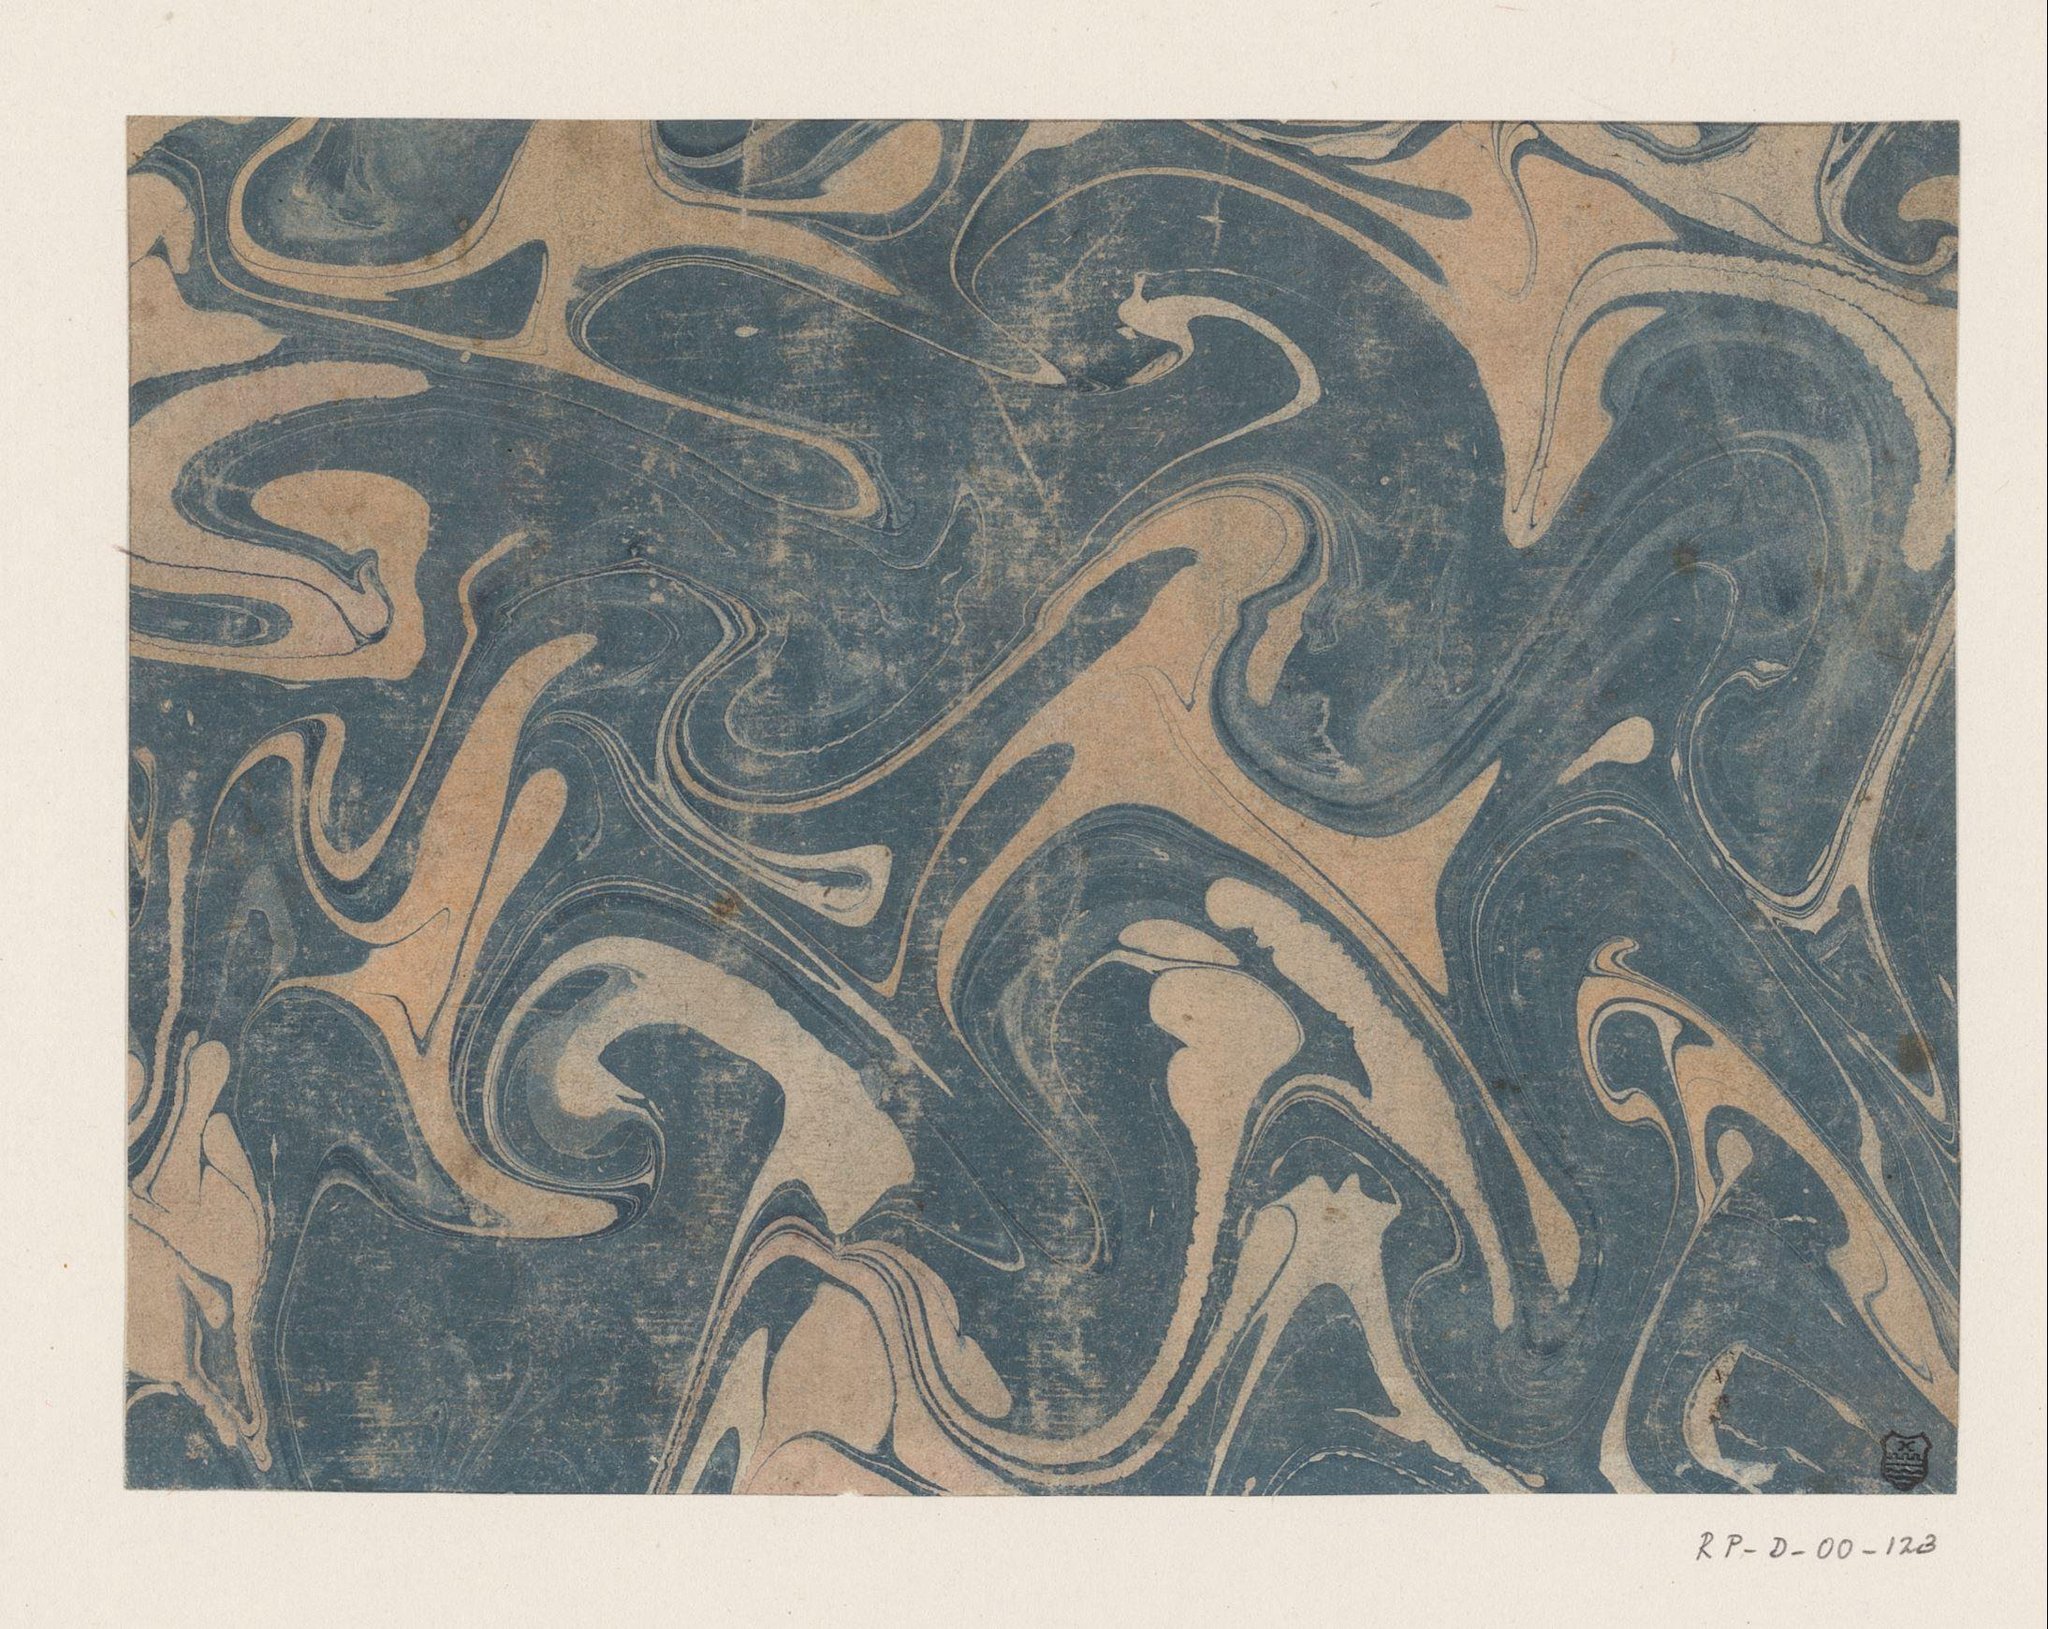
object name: marbled paper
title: Fantasie- of lussenmarmer in blauw en roze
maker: Anonymous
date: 1700-1850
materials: paint, paper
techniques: marbled paper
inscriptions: collector's mark: Lugt 2760